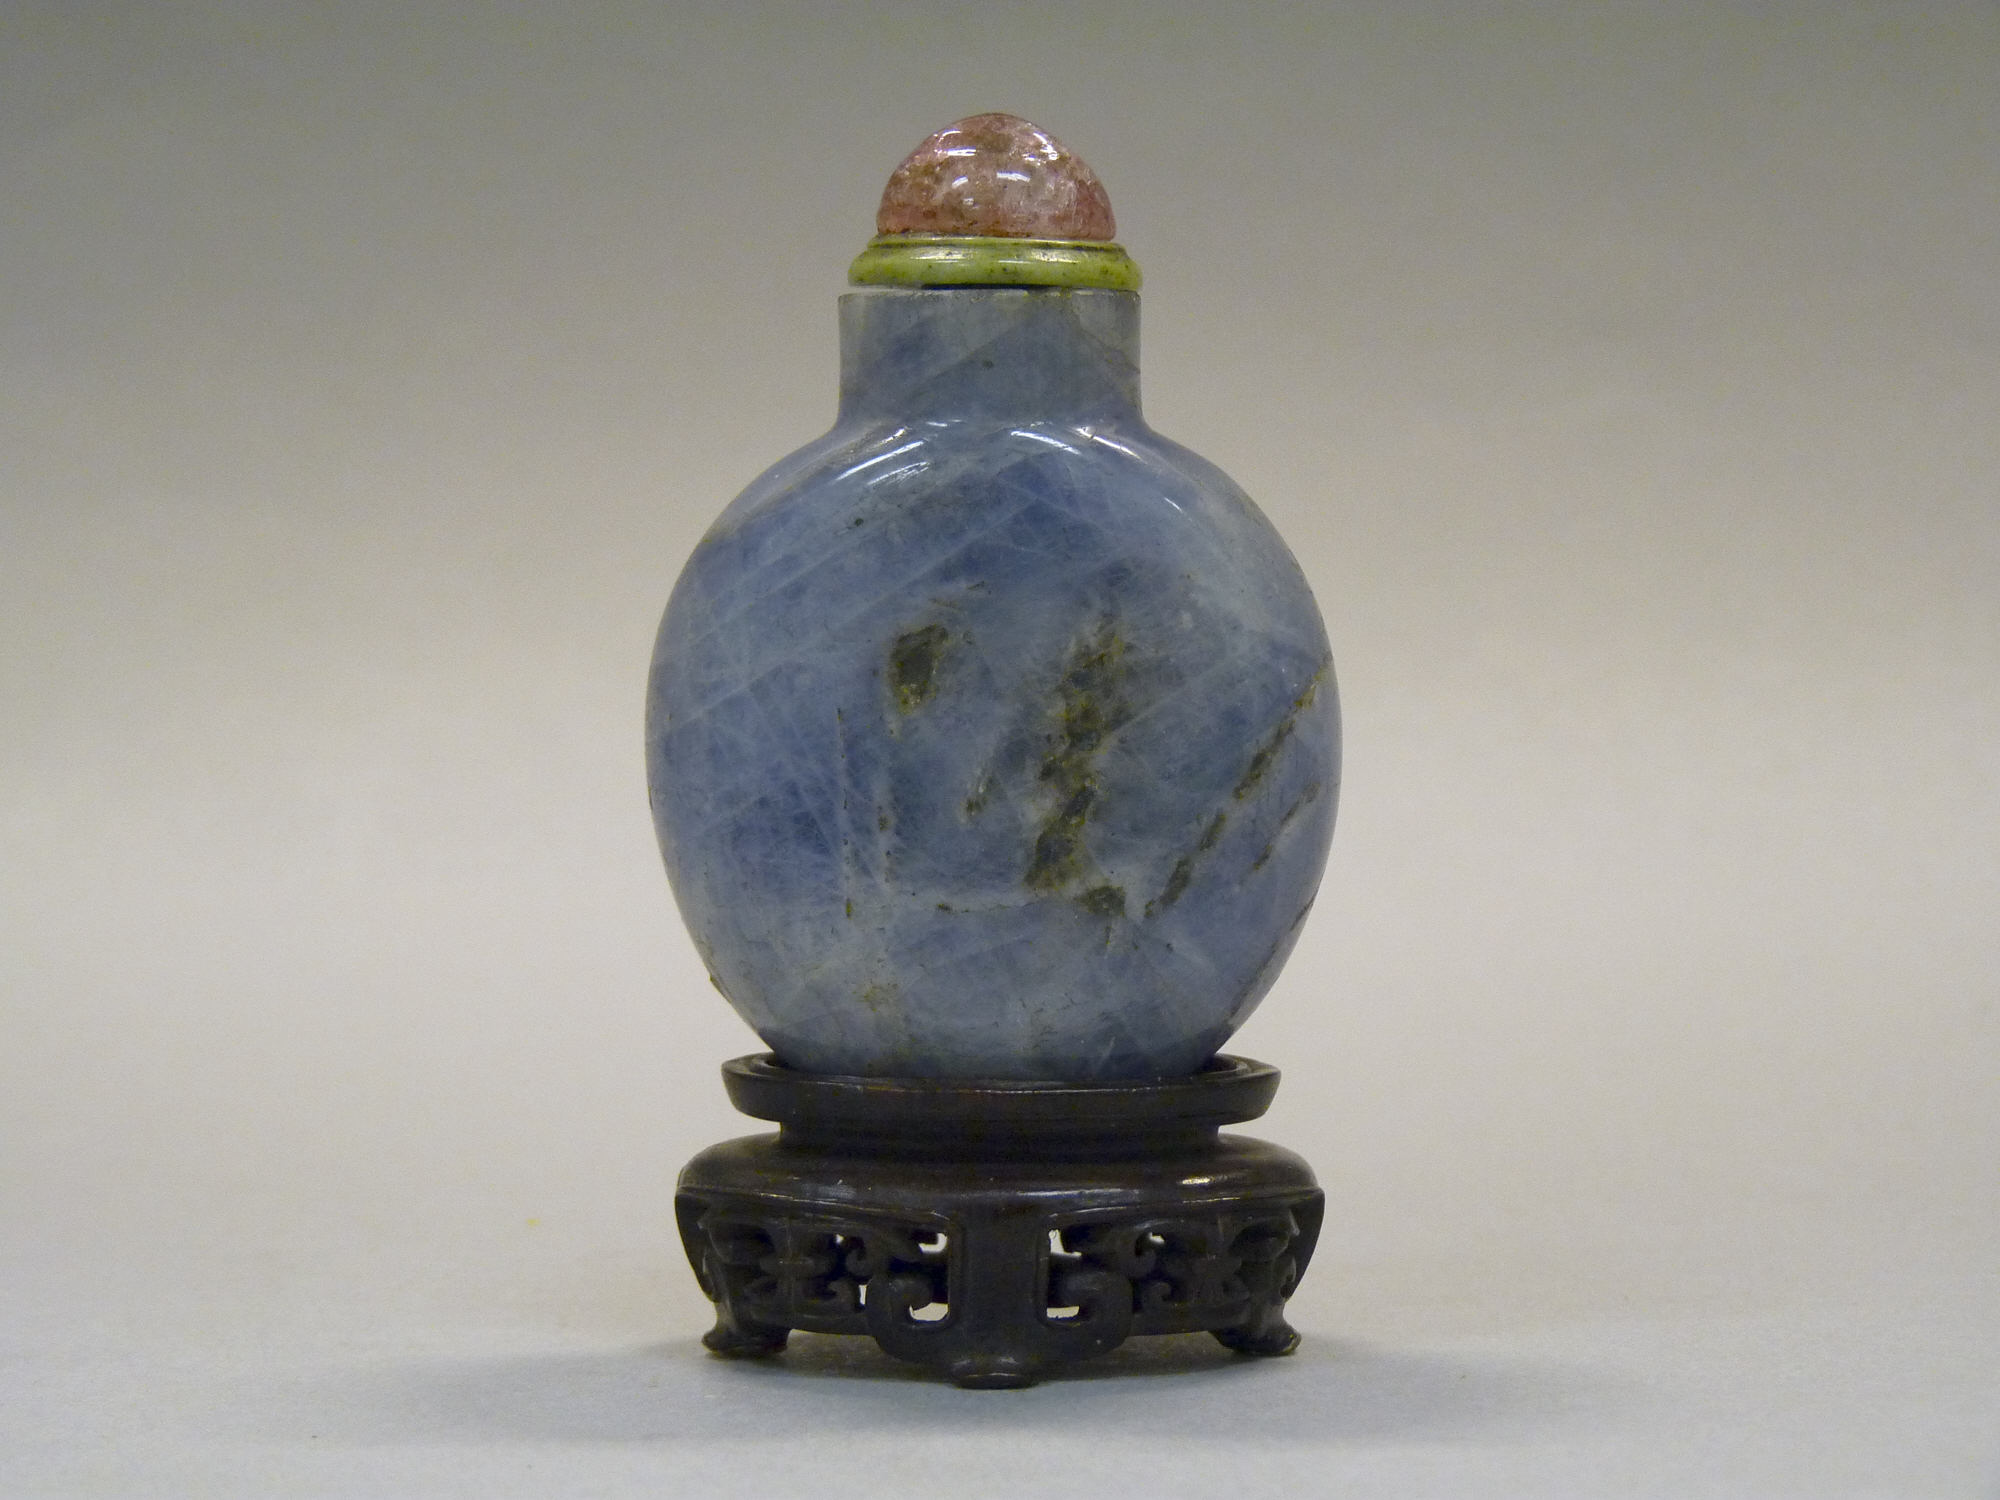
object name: snuff bottle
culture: chinese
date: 1801-1900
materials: glass, gemstone